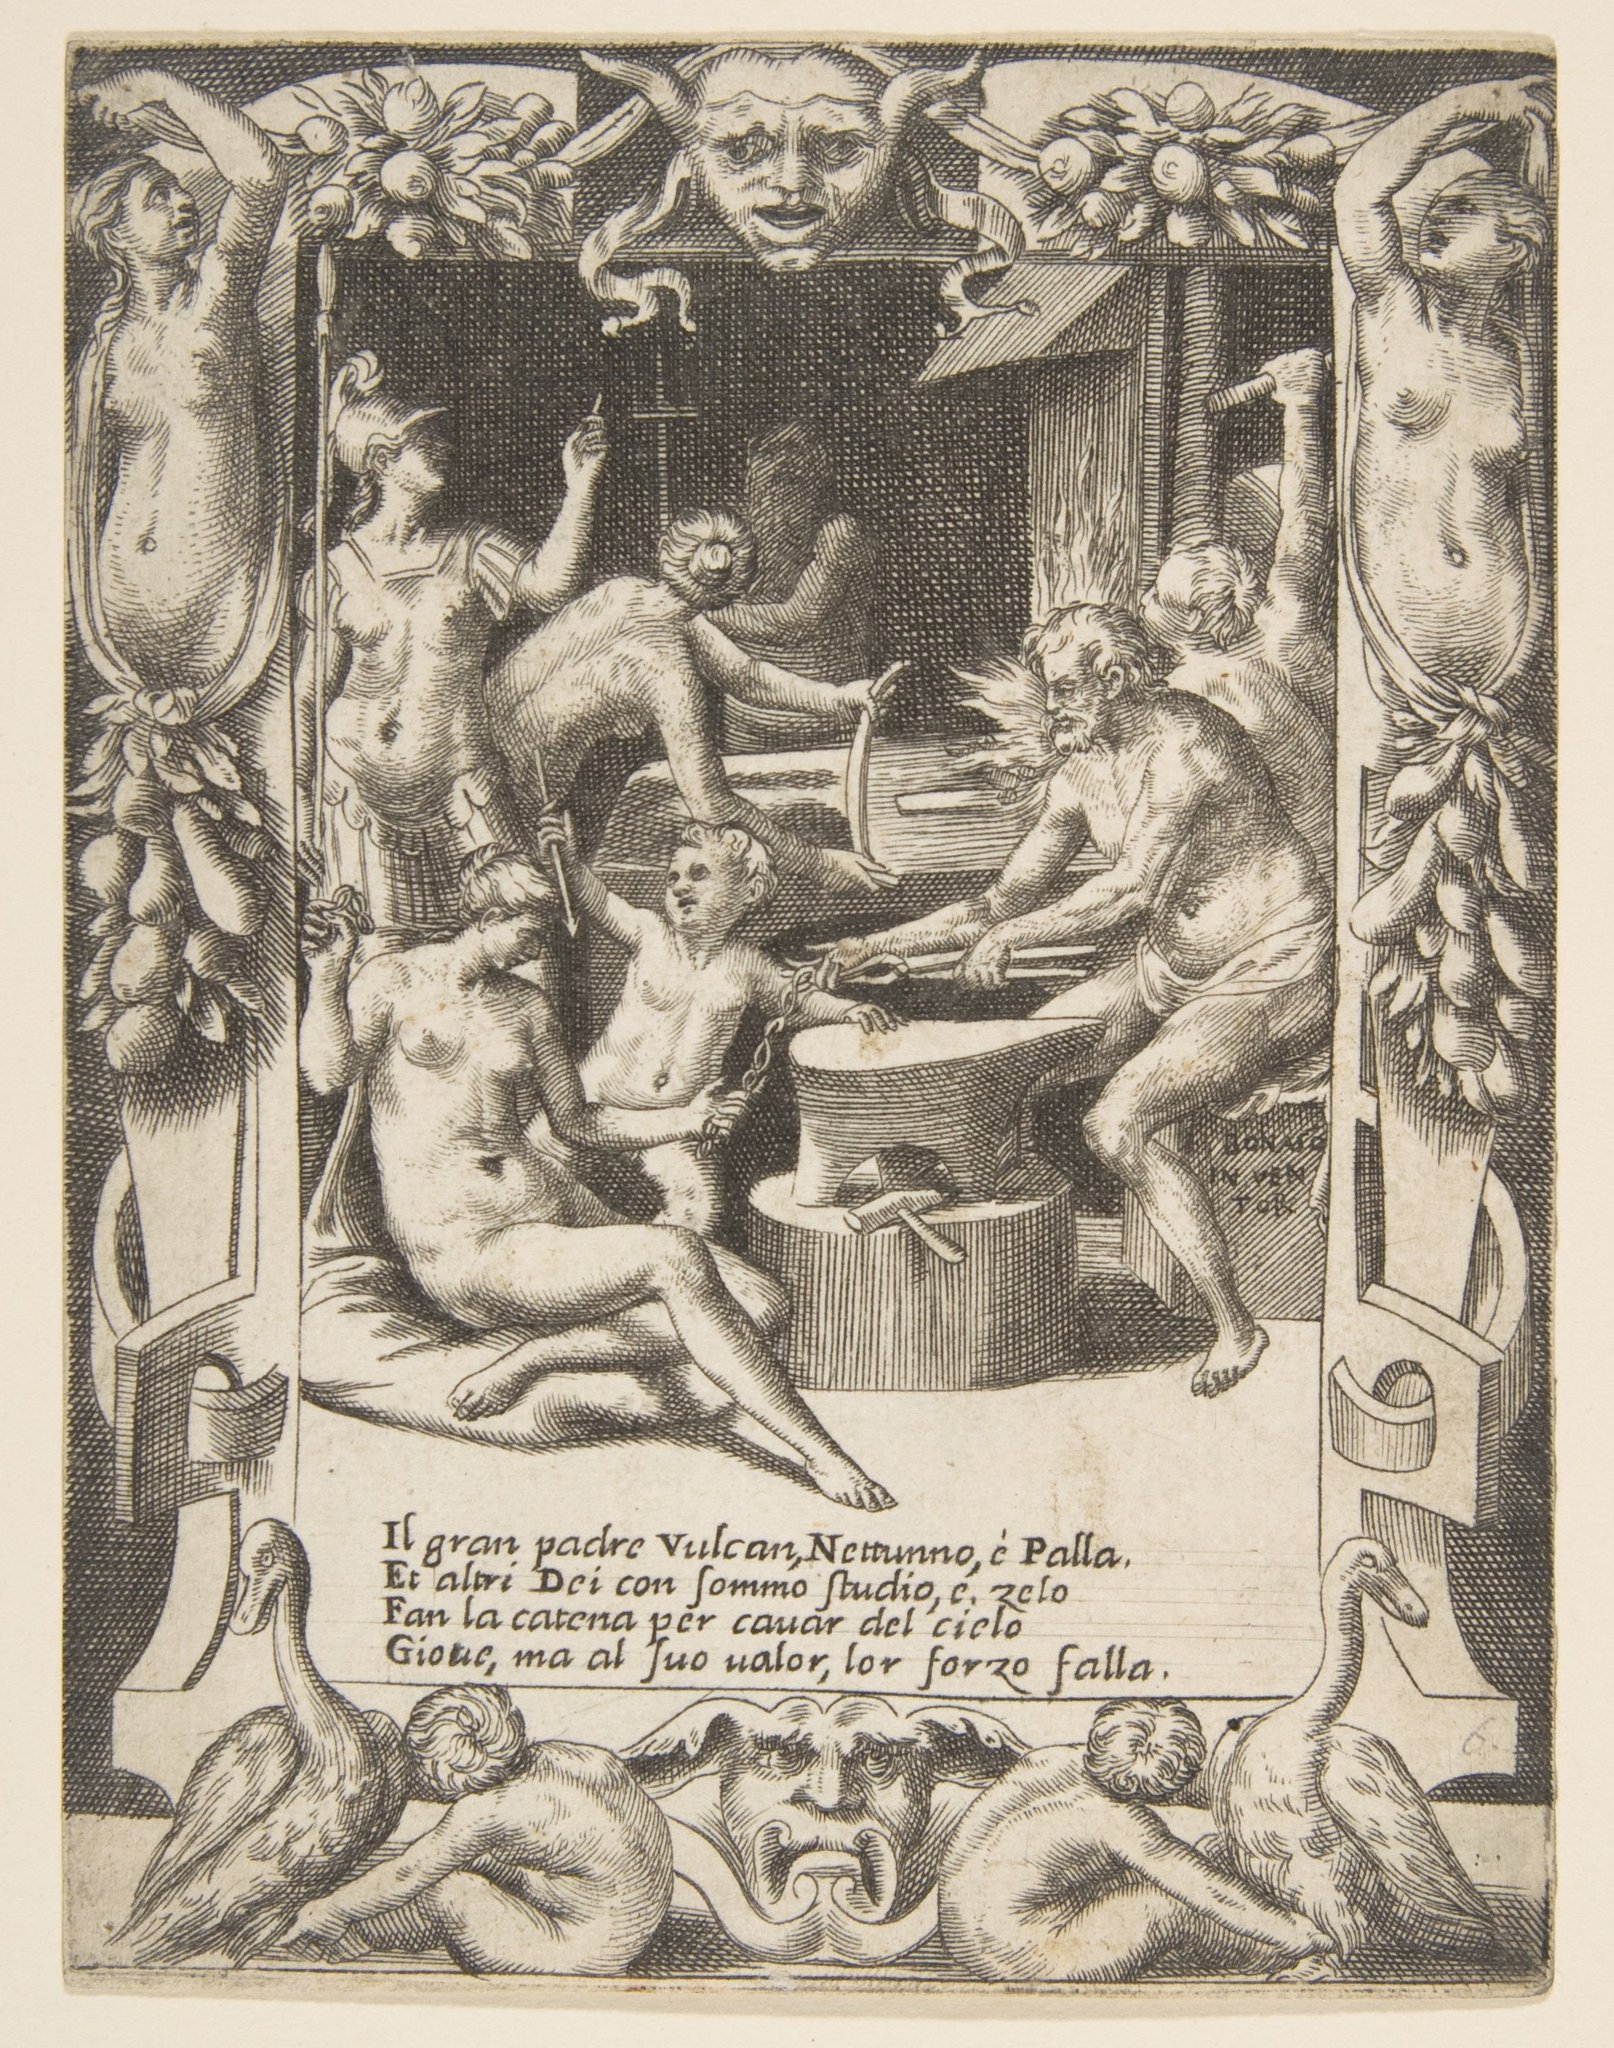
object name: print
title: Vulcan, Neptune, Athena and other Gods making Shackles to pull Jupiter from the Heavens, set within an elaborate frame, from "Loves, Rages and Jealousies of Juno"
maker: giulio bonasone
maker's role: artist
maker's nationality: italian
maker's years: 1510-1576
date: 1531-1576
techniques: engraving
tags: birds,faces,athena,neptune,vulcan